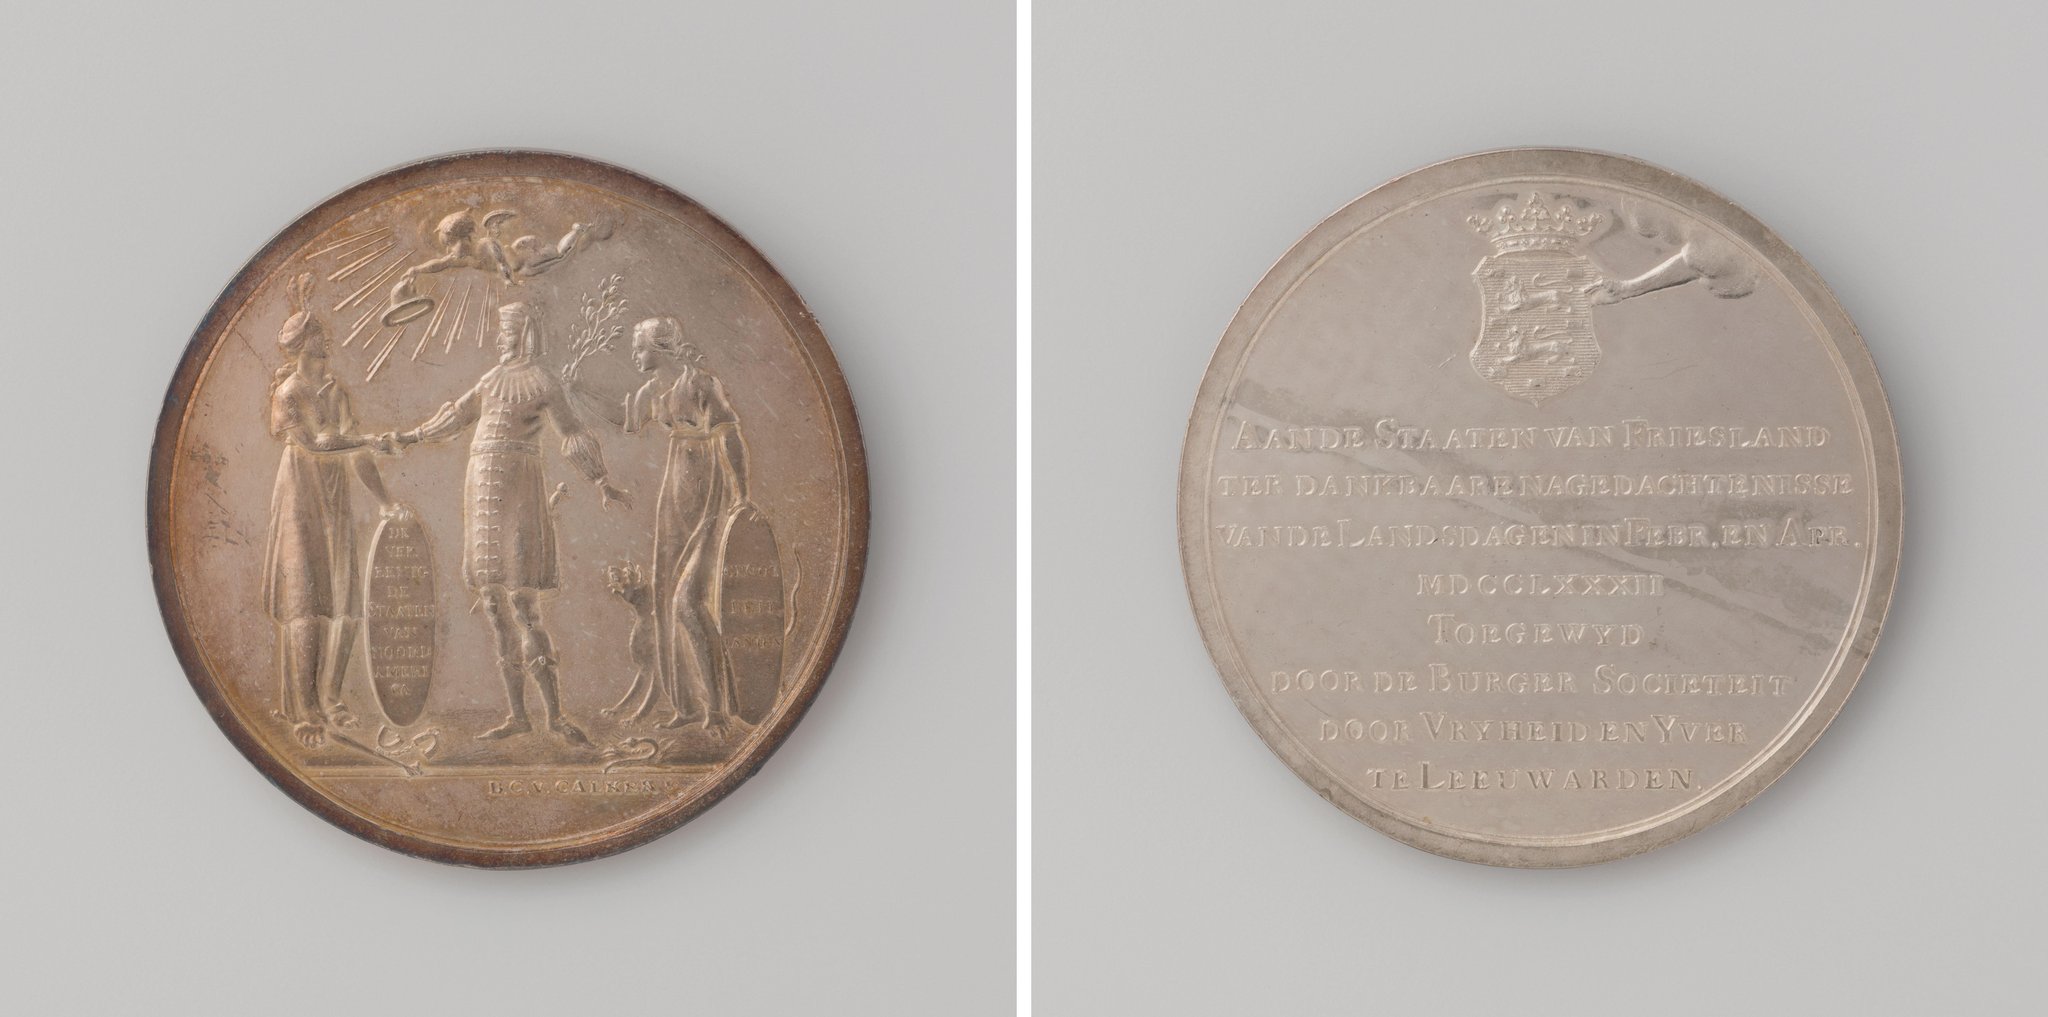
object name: history medal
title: Besluit van de landdag van de Staten van Friesland, betreffende het aanvaarden van John Adams als gezant van de Verenigde Staten van Amerika en het afwijzen van een afzonderlijke vrede met Engeland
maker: barend christiaan van calker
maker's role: medailleur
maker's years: 1739-1813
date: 1782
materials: silver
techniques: striking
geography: zeist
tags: united states of america